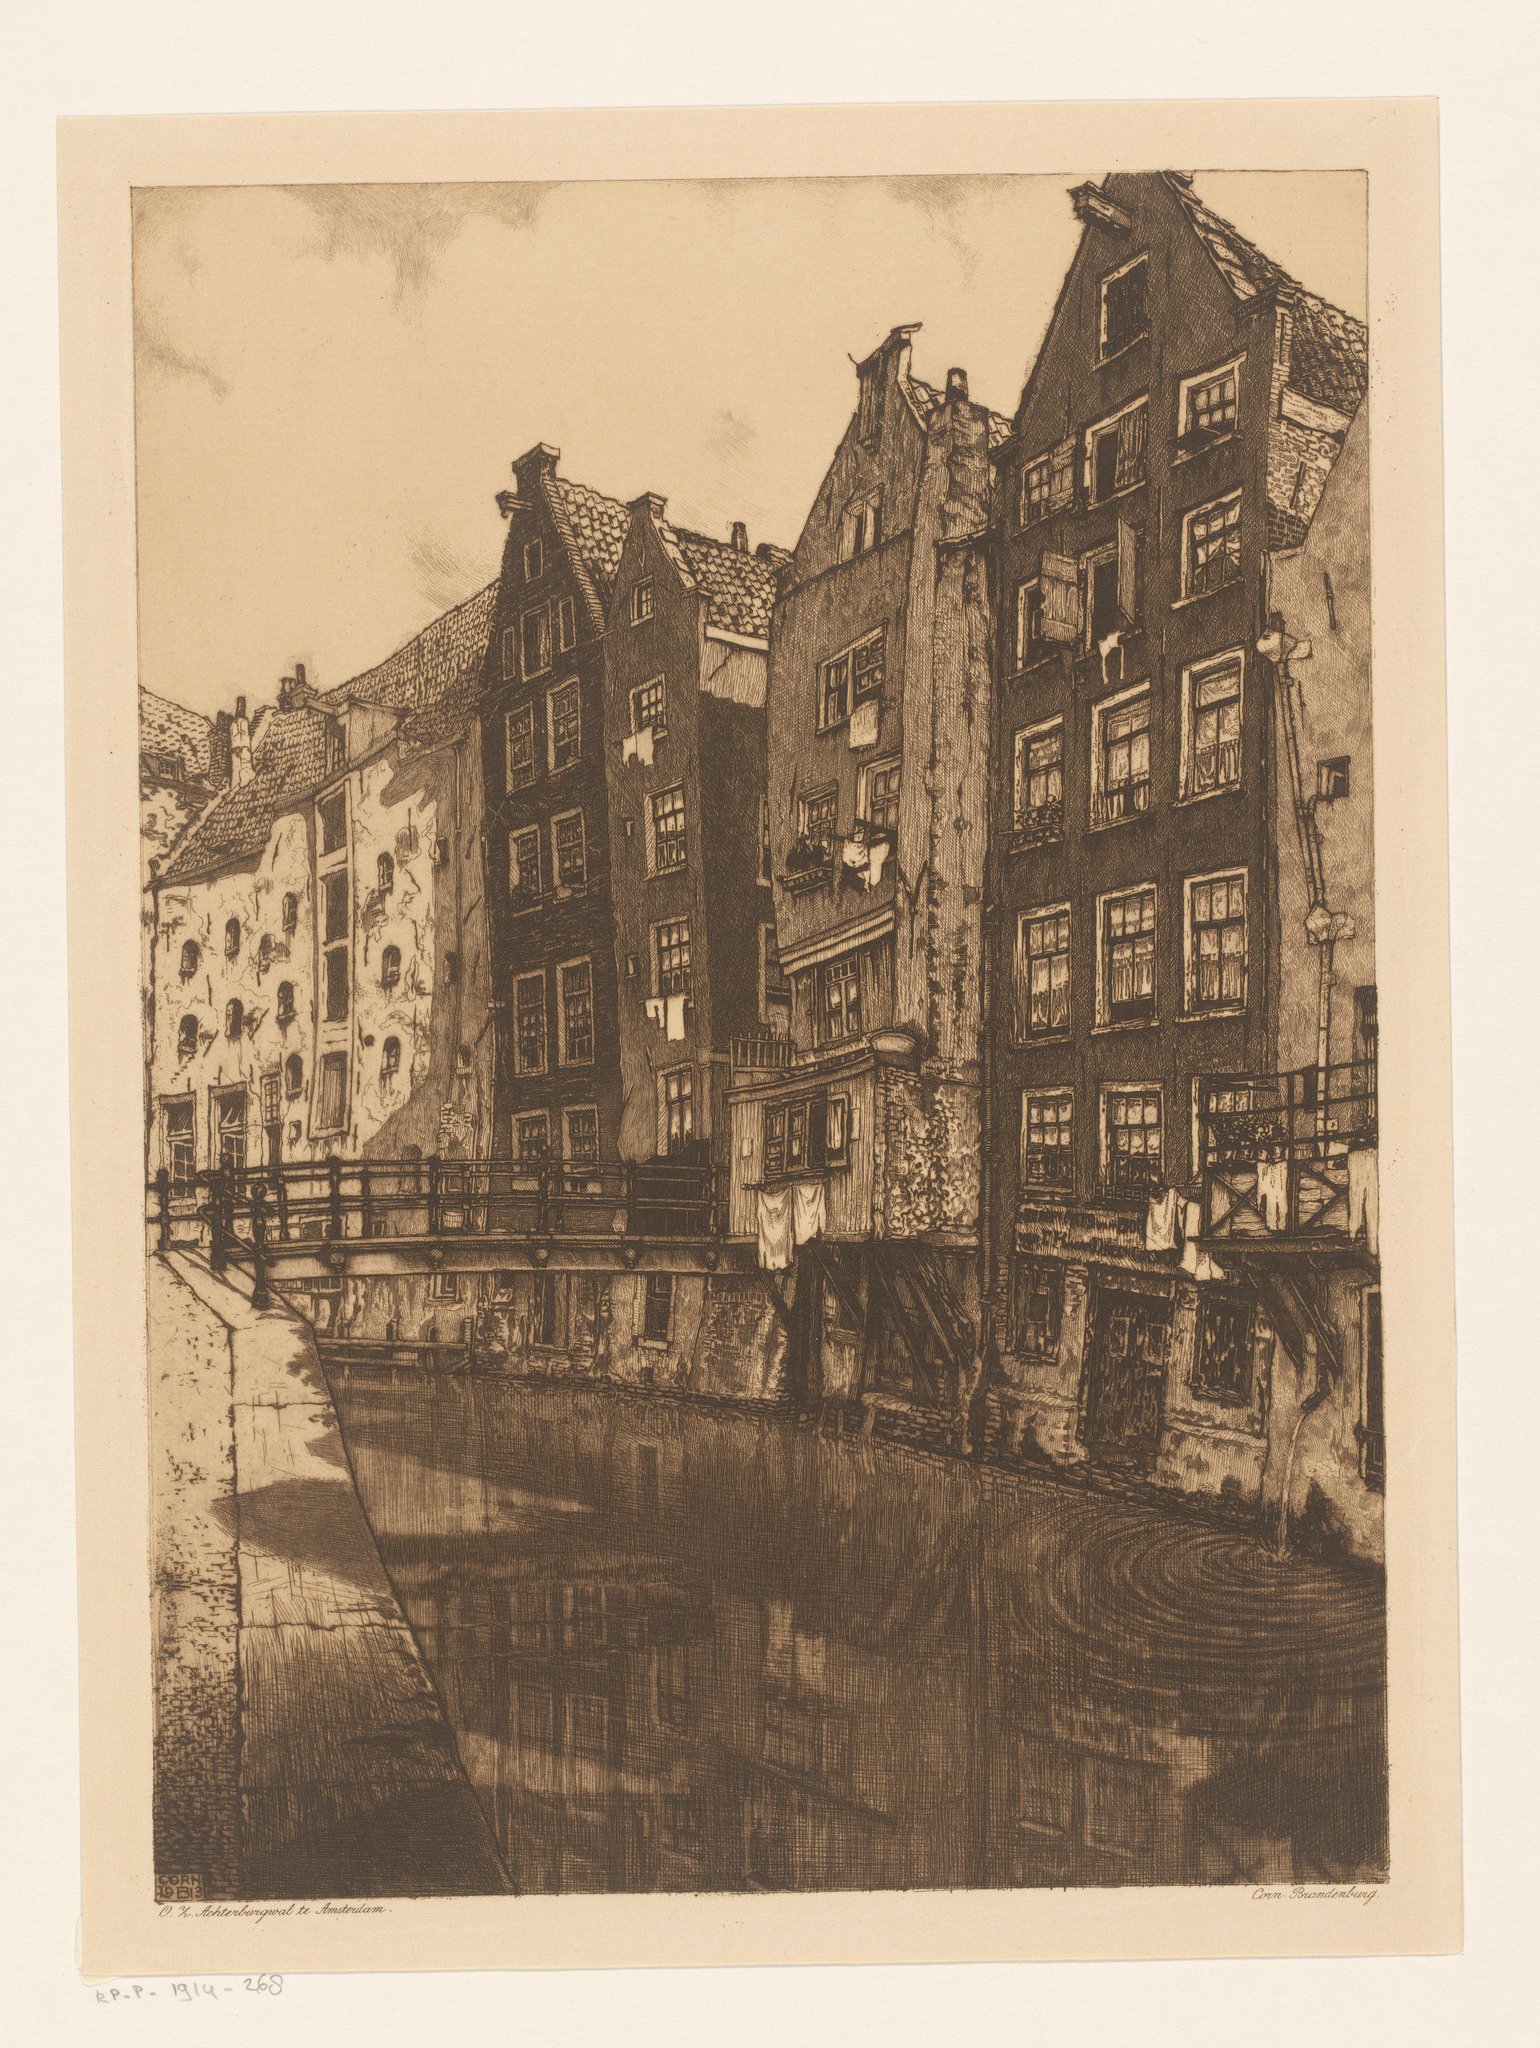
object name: print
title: Oudezijds Achterburgwal te Amsterdam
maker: cornelis brandenburg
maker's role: print maker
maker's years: 1884-1954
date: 1913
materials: paper, ink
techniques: drypoint, etching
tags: canals, waters (in city)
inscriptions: signature: ‘Corn. Brandenburg’, title: ‘O.Z. Achterburgwal te Amsterdam’, monogram and date: ‘CORN/ 19B13’, collector's mark: Lugt 2233, label: ‘PREMIE 1914. -ST. LUCAS VEREENIGING TOT AANMOEDIGING VAN BEELDENDE KUNSTEN’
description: Gezicht op de Oudezijds Achterburgwal met rechts grachtenpanden, links de kade en in het midden de gracht met een brug.